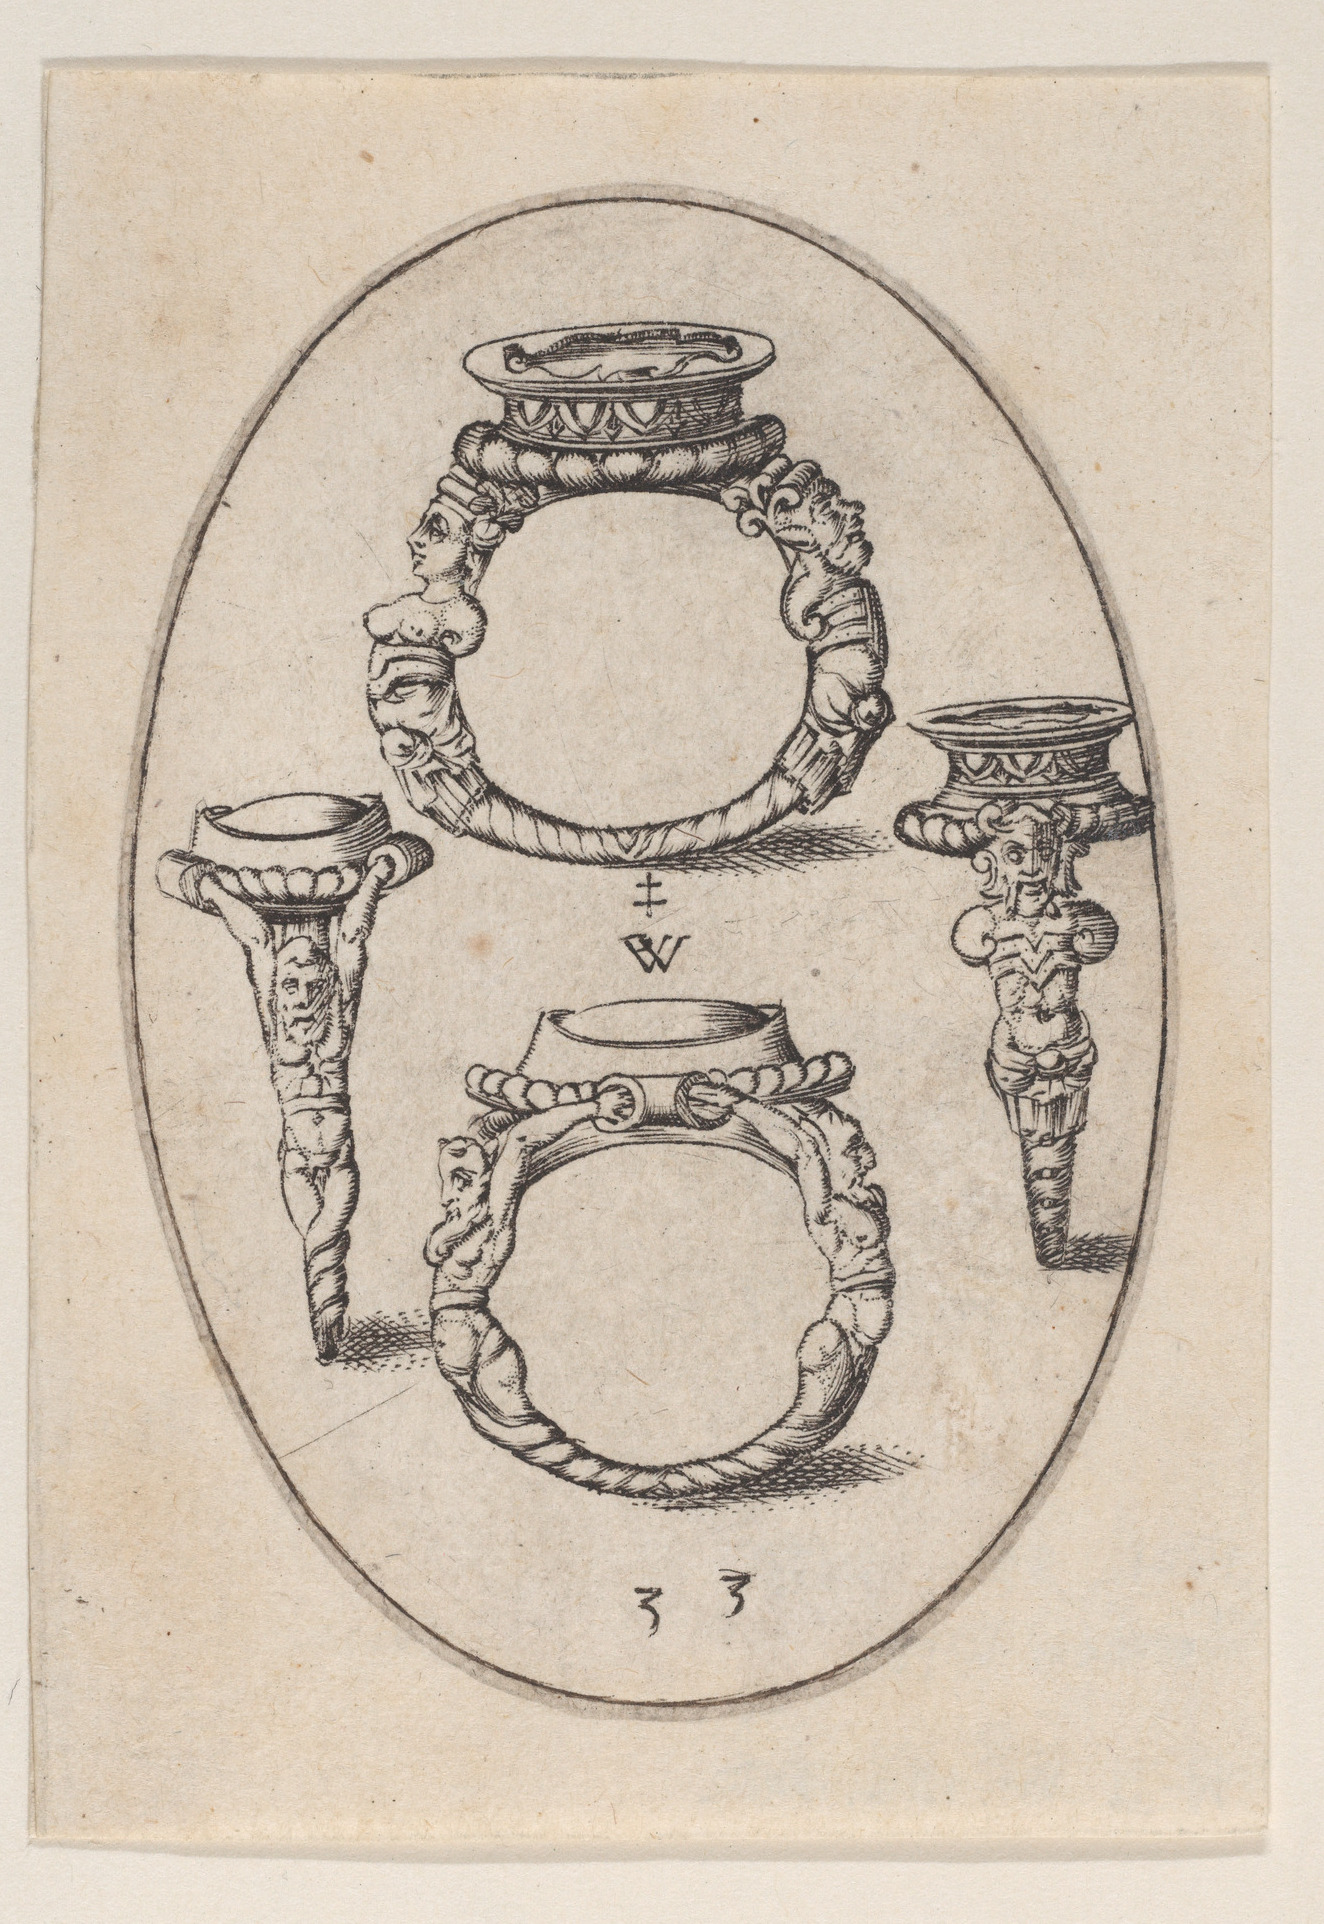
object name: print ornament architecture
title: Designs for Four Rings, Plate 33 from 'Livre d'Aneaux d'Orfevrerie'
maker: pierre woeiriot de bouzey ii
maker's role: artist and engraver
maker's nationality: french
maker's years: 1532-1599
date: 1561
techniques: engraving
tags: rings